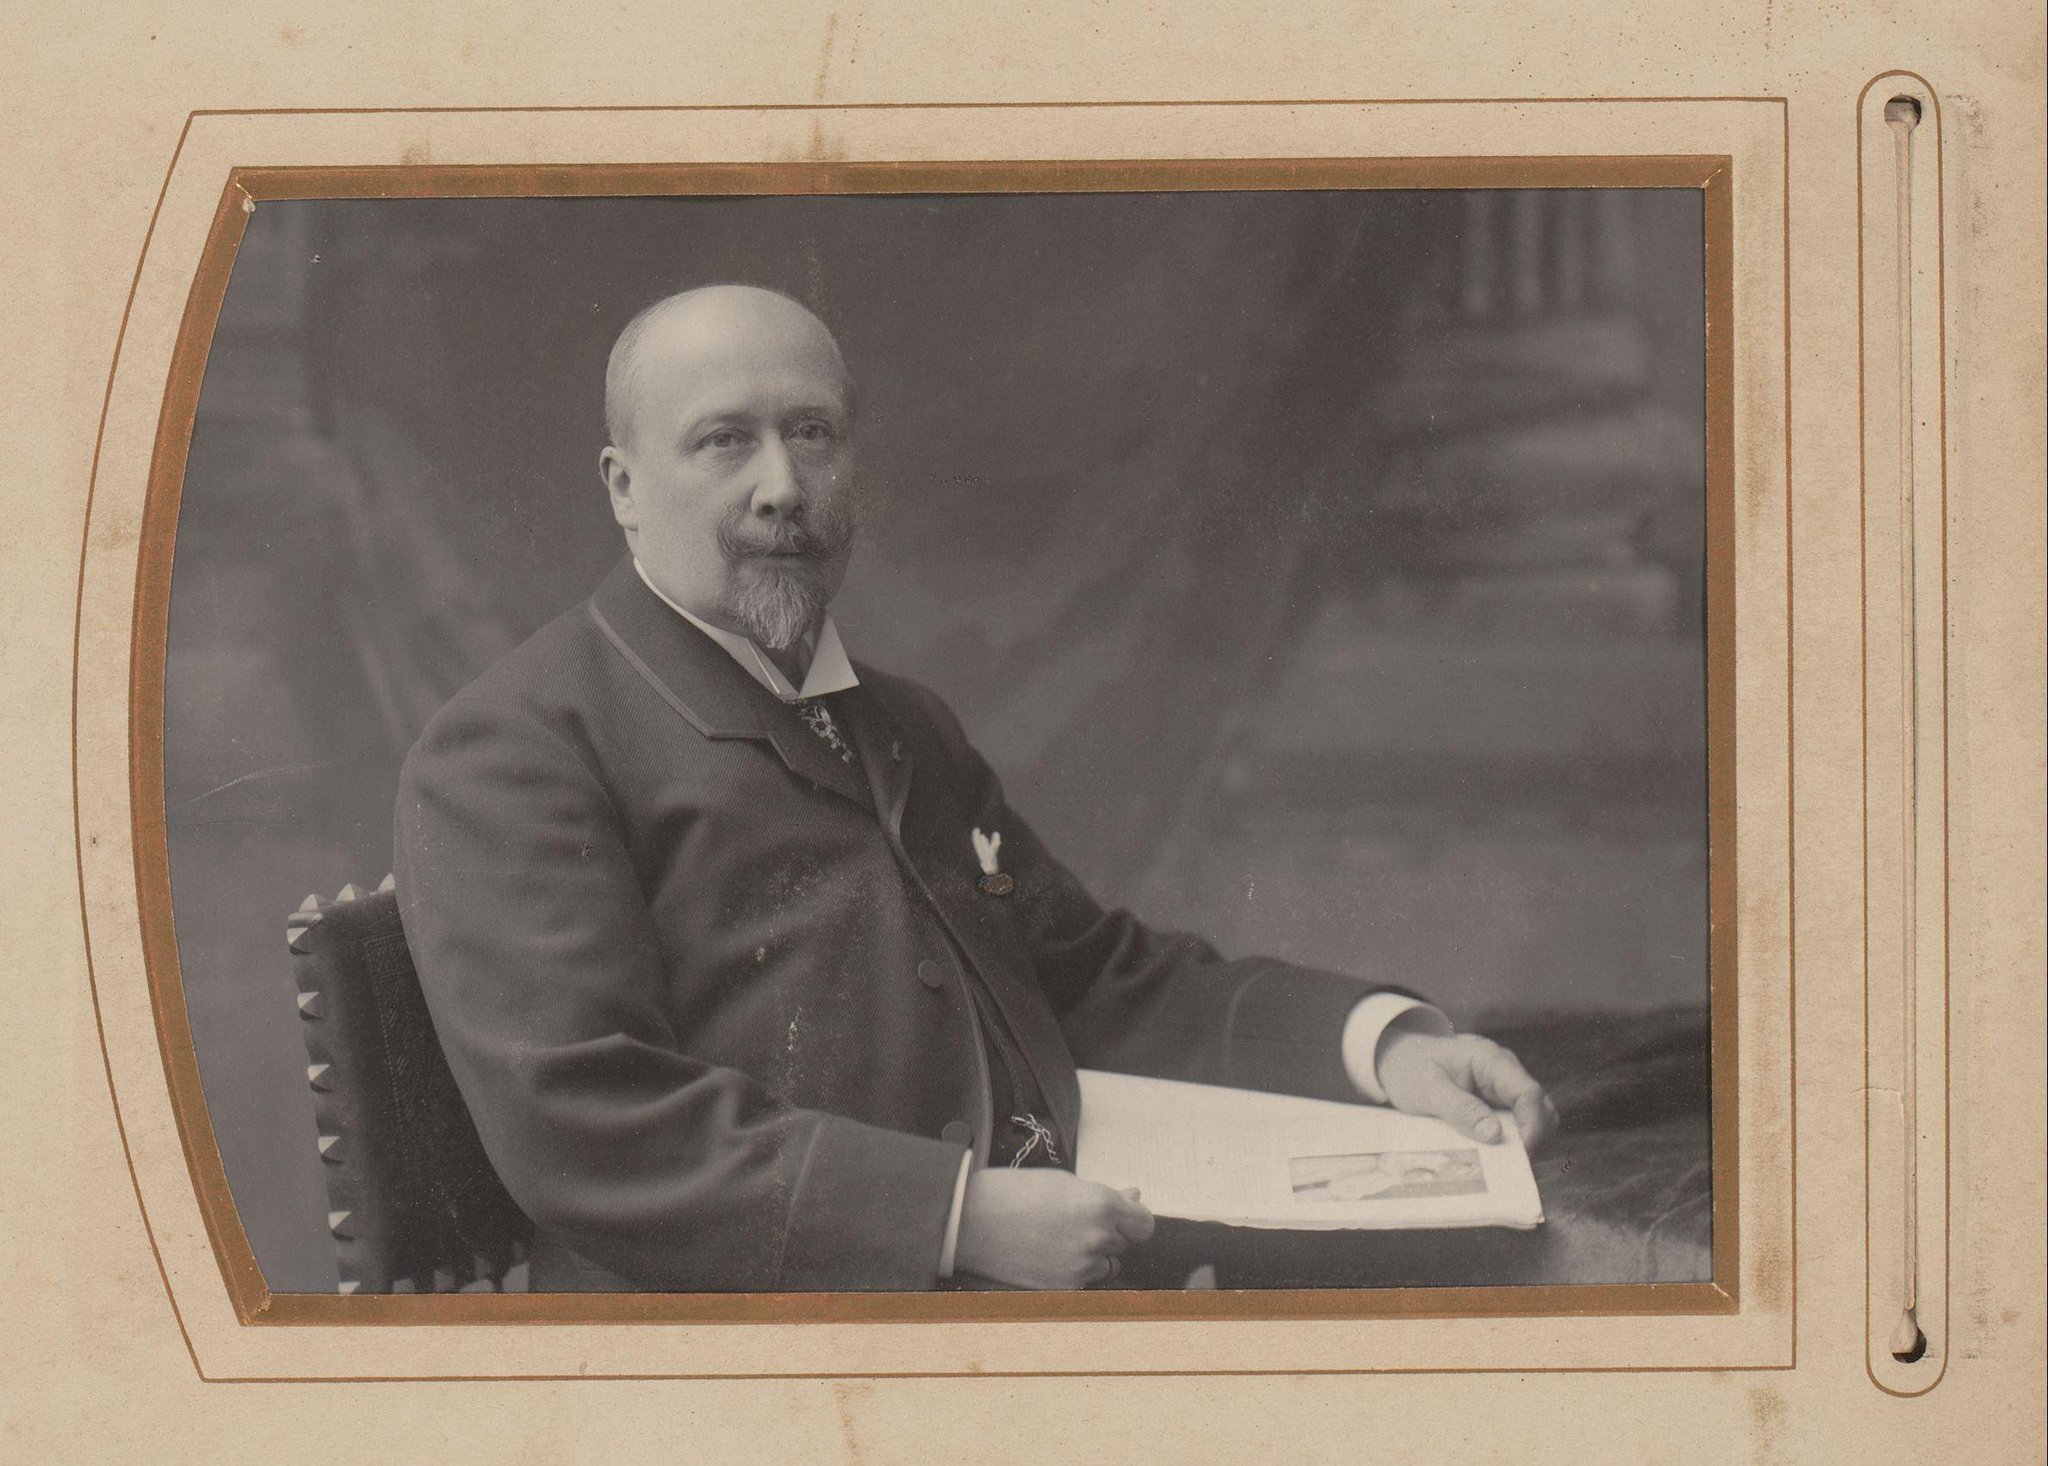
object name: cabinet photograph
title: Portret van een zittende man met sik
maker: ferdinand buyle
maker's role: fotograaf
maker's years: 1872-1950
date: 1905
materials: cardboard, photographic support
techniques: matte daylight collodion silver print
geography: brussels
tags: sitting figure, historical persons, beard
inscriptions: dedication: ‘A mon excellent ami H[...] Van H[..]re/ souvenir affectueux/ [Jan] Chau[.]ette des[...]/ Bruxelles 3 Janvier 1905’, inscription: ‘Ferd. Buyle/ 104, Marché-aux-Herbes/ Bruxelles.’